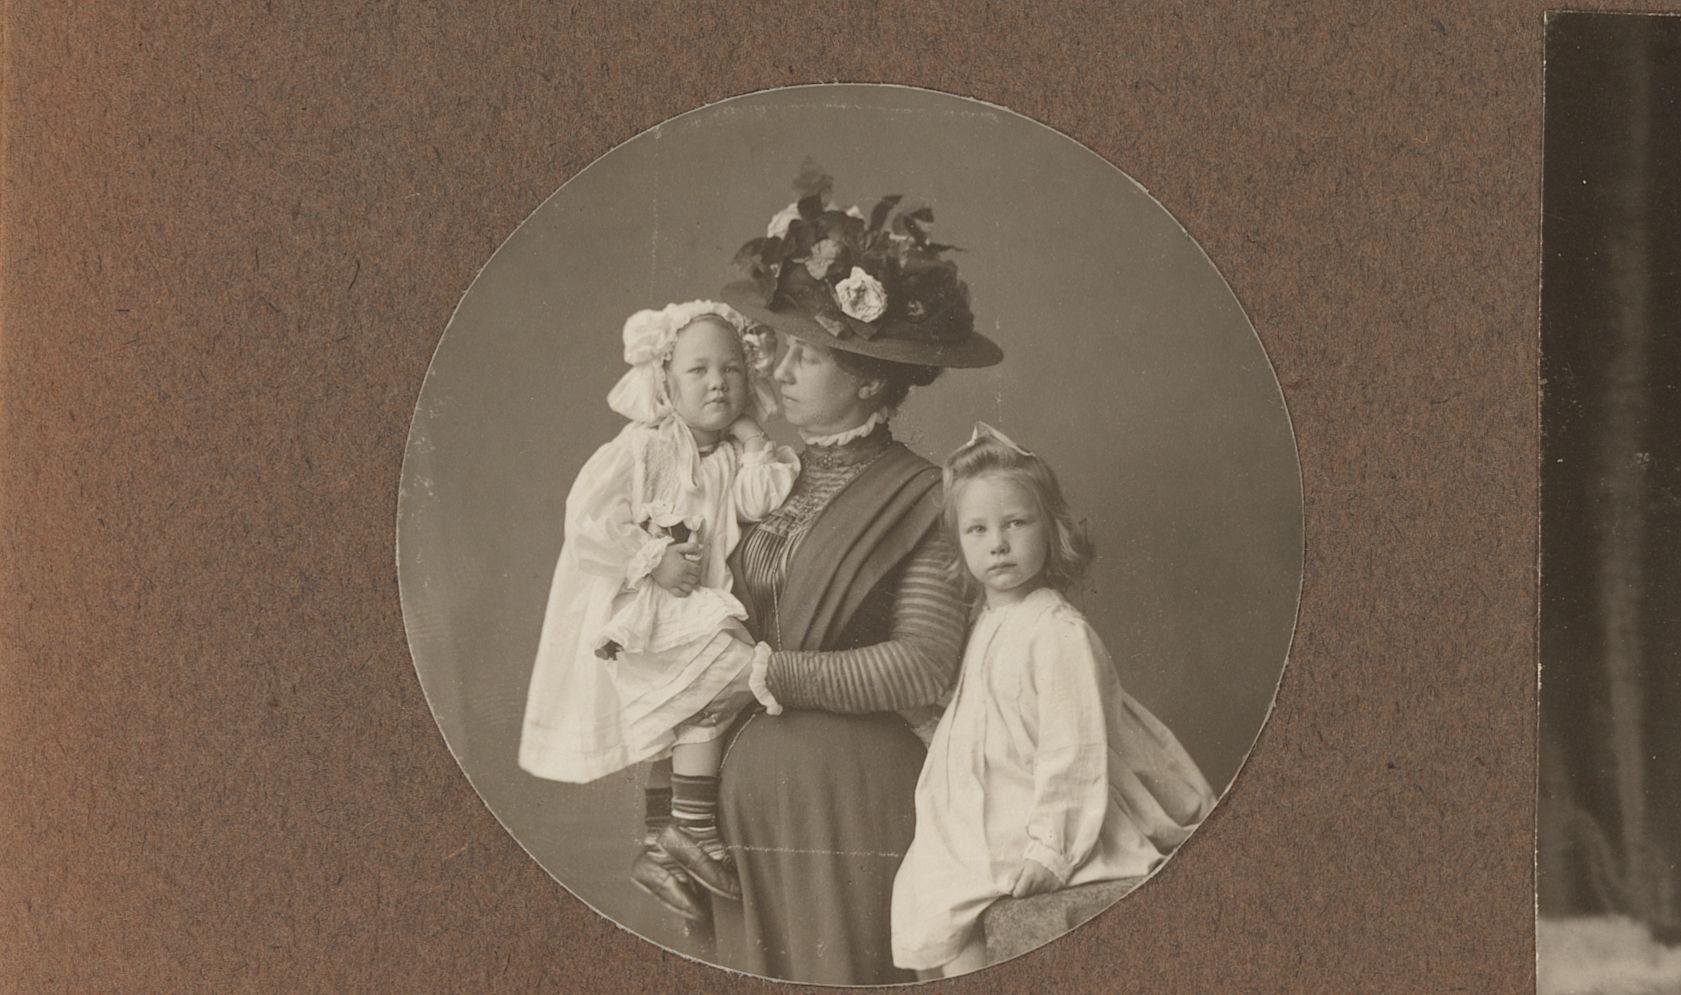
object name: photograph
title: Mevrouw Diepenbrock met haar twee dochters Thea en Joanna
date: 1870-1920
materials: photographic support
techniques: photography, snipping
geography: amsterdam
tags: jonkvrouw wilhelmina elisabeth petronella cornelia de jong van beek en donk, netherlands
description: Foto op bruin albumblad 44 van familiealbum van Alphons Diepenbrock.